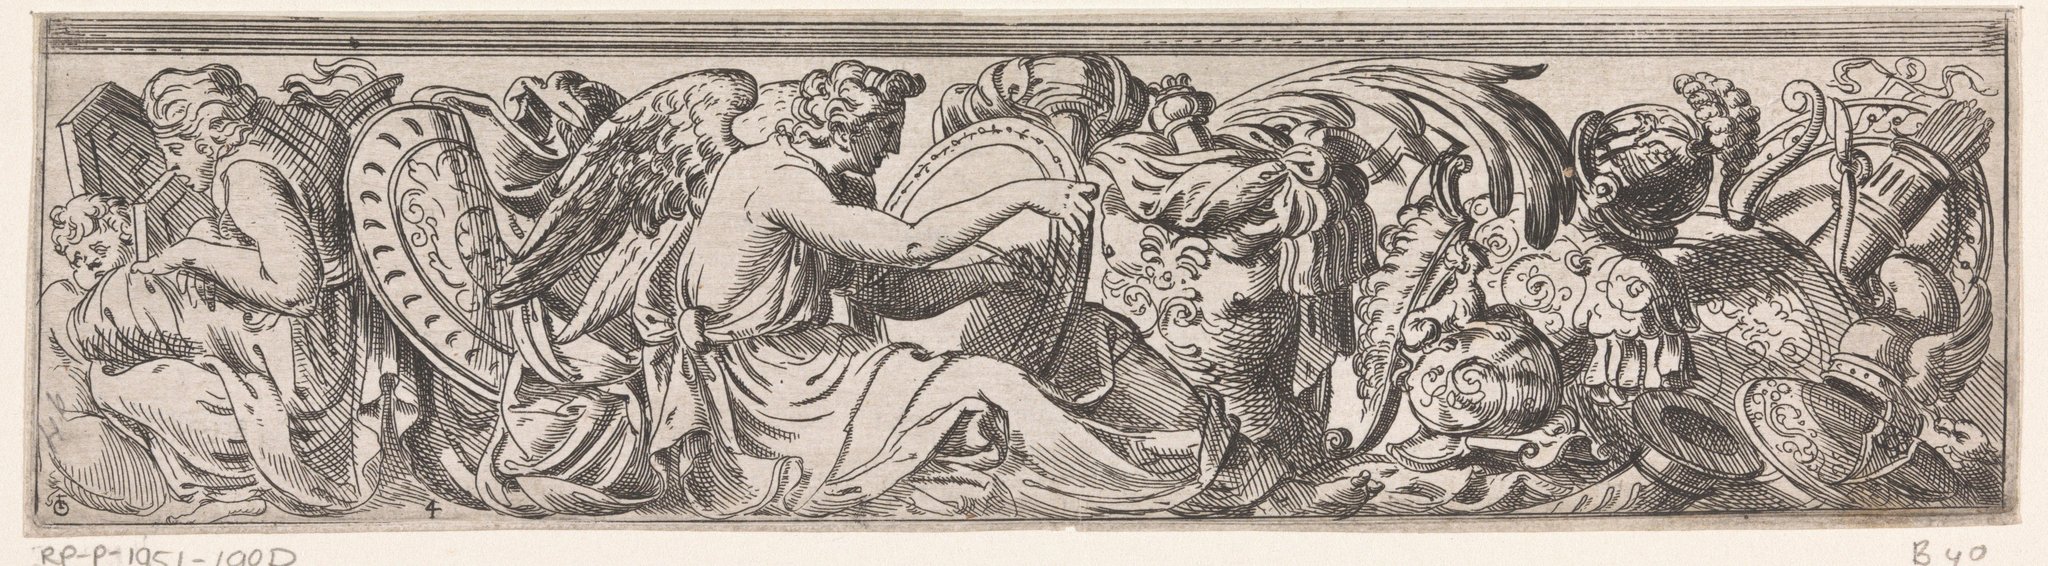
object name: print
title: Fries met de personificatie van Geschiedenis op een rond tablet schrijvend tussen wapens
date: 1583-1638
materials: paper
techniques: etching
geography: vatican city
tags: sitting figure, weapons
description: Prent uit een reeks van vijf prenten, plus titelprent.